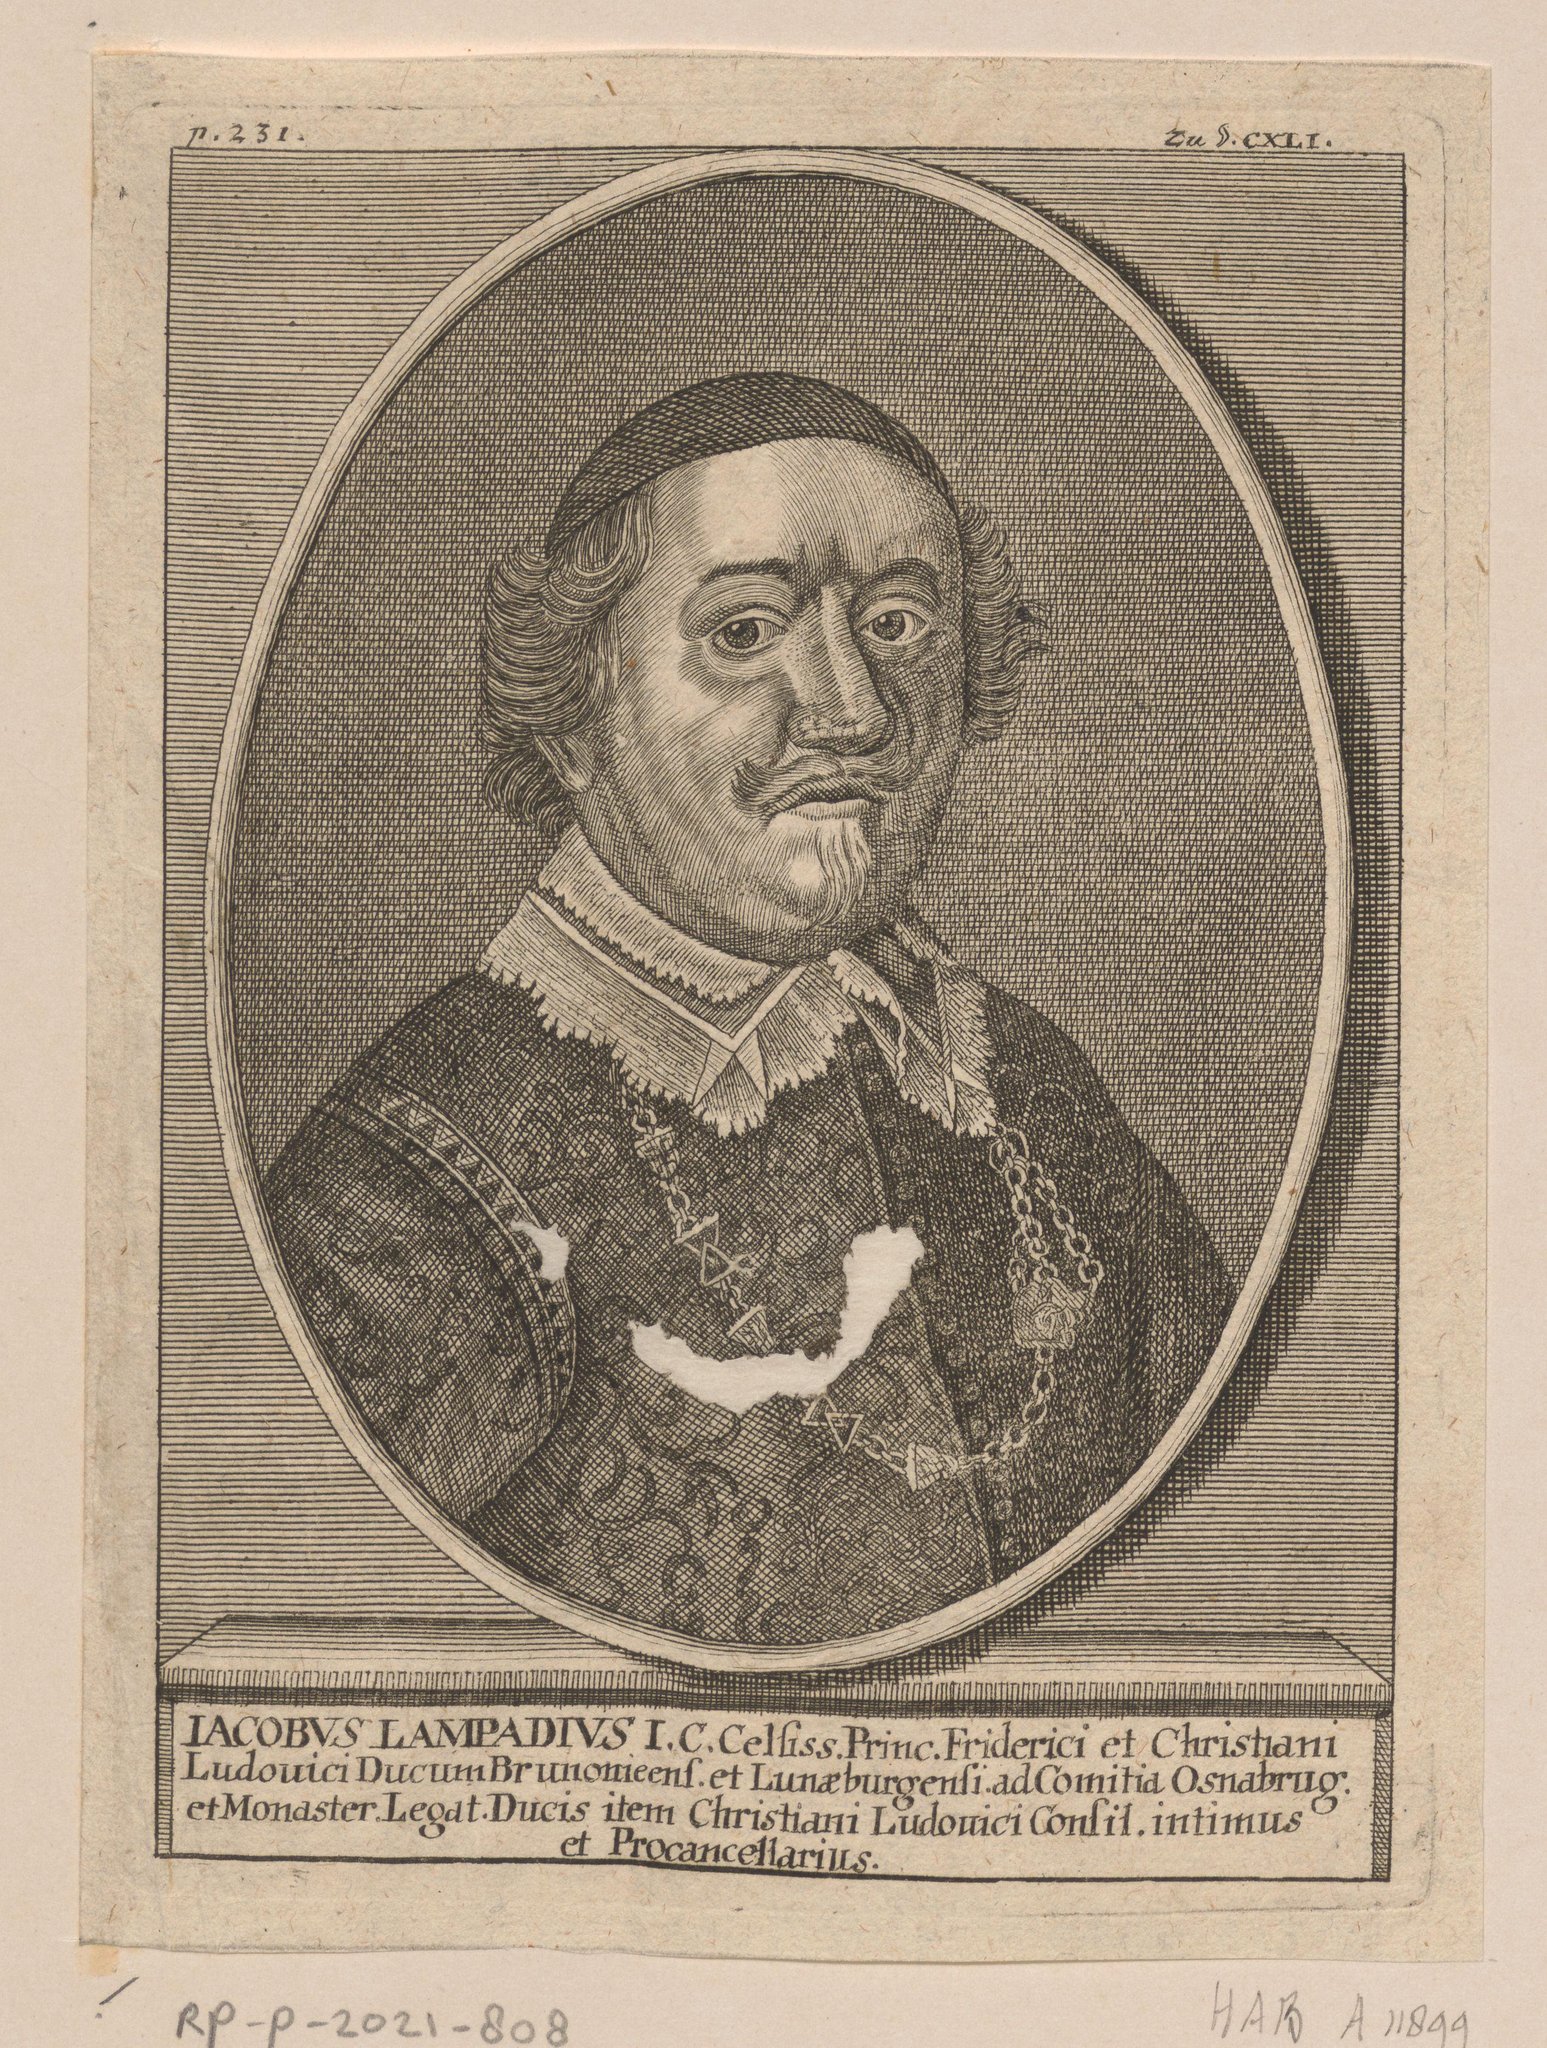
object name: print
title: Portret van Jakob Lampadius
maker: Anonymous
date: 1744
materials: paper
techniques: engraving, etching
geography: germany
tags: historical persons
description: Prent waarschijnlijk uit: Baring, Daniel Eberhard. Descriptio Salae principatus Calenbergici locorumque adiacentium Oder Beschreibung (...). Lemgo: Johann Heinrich Meyer, 1744.